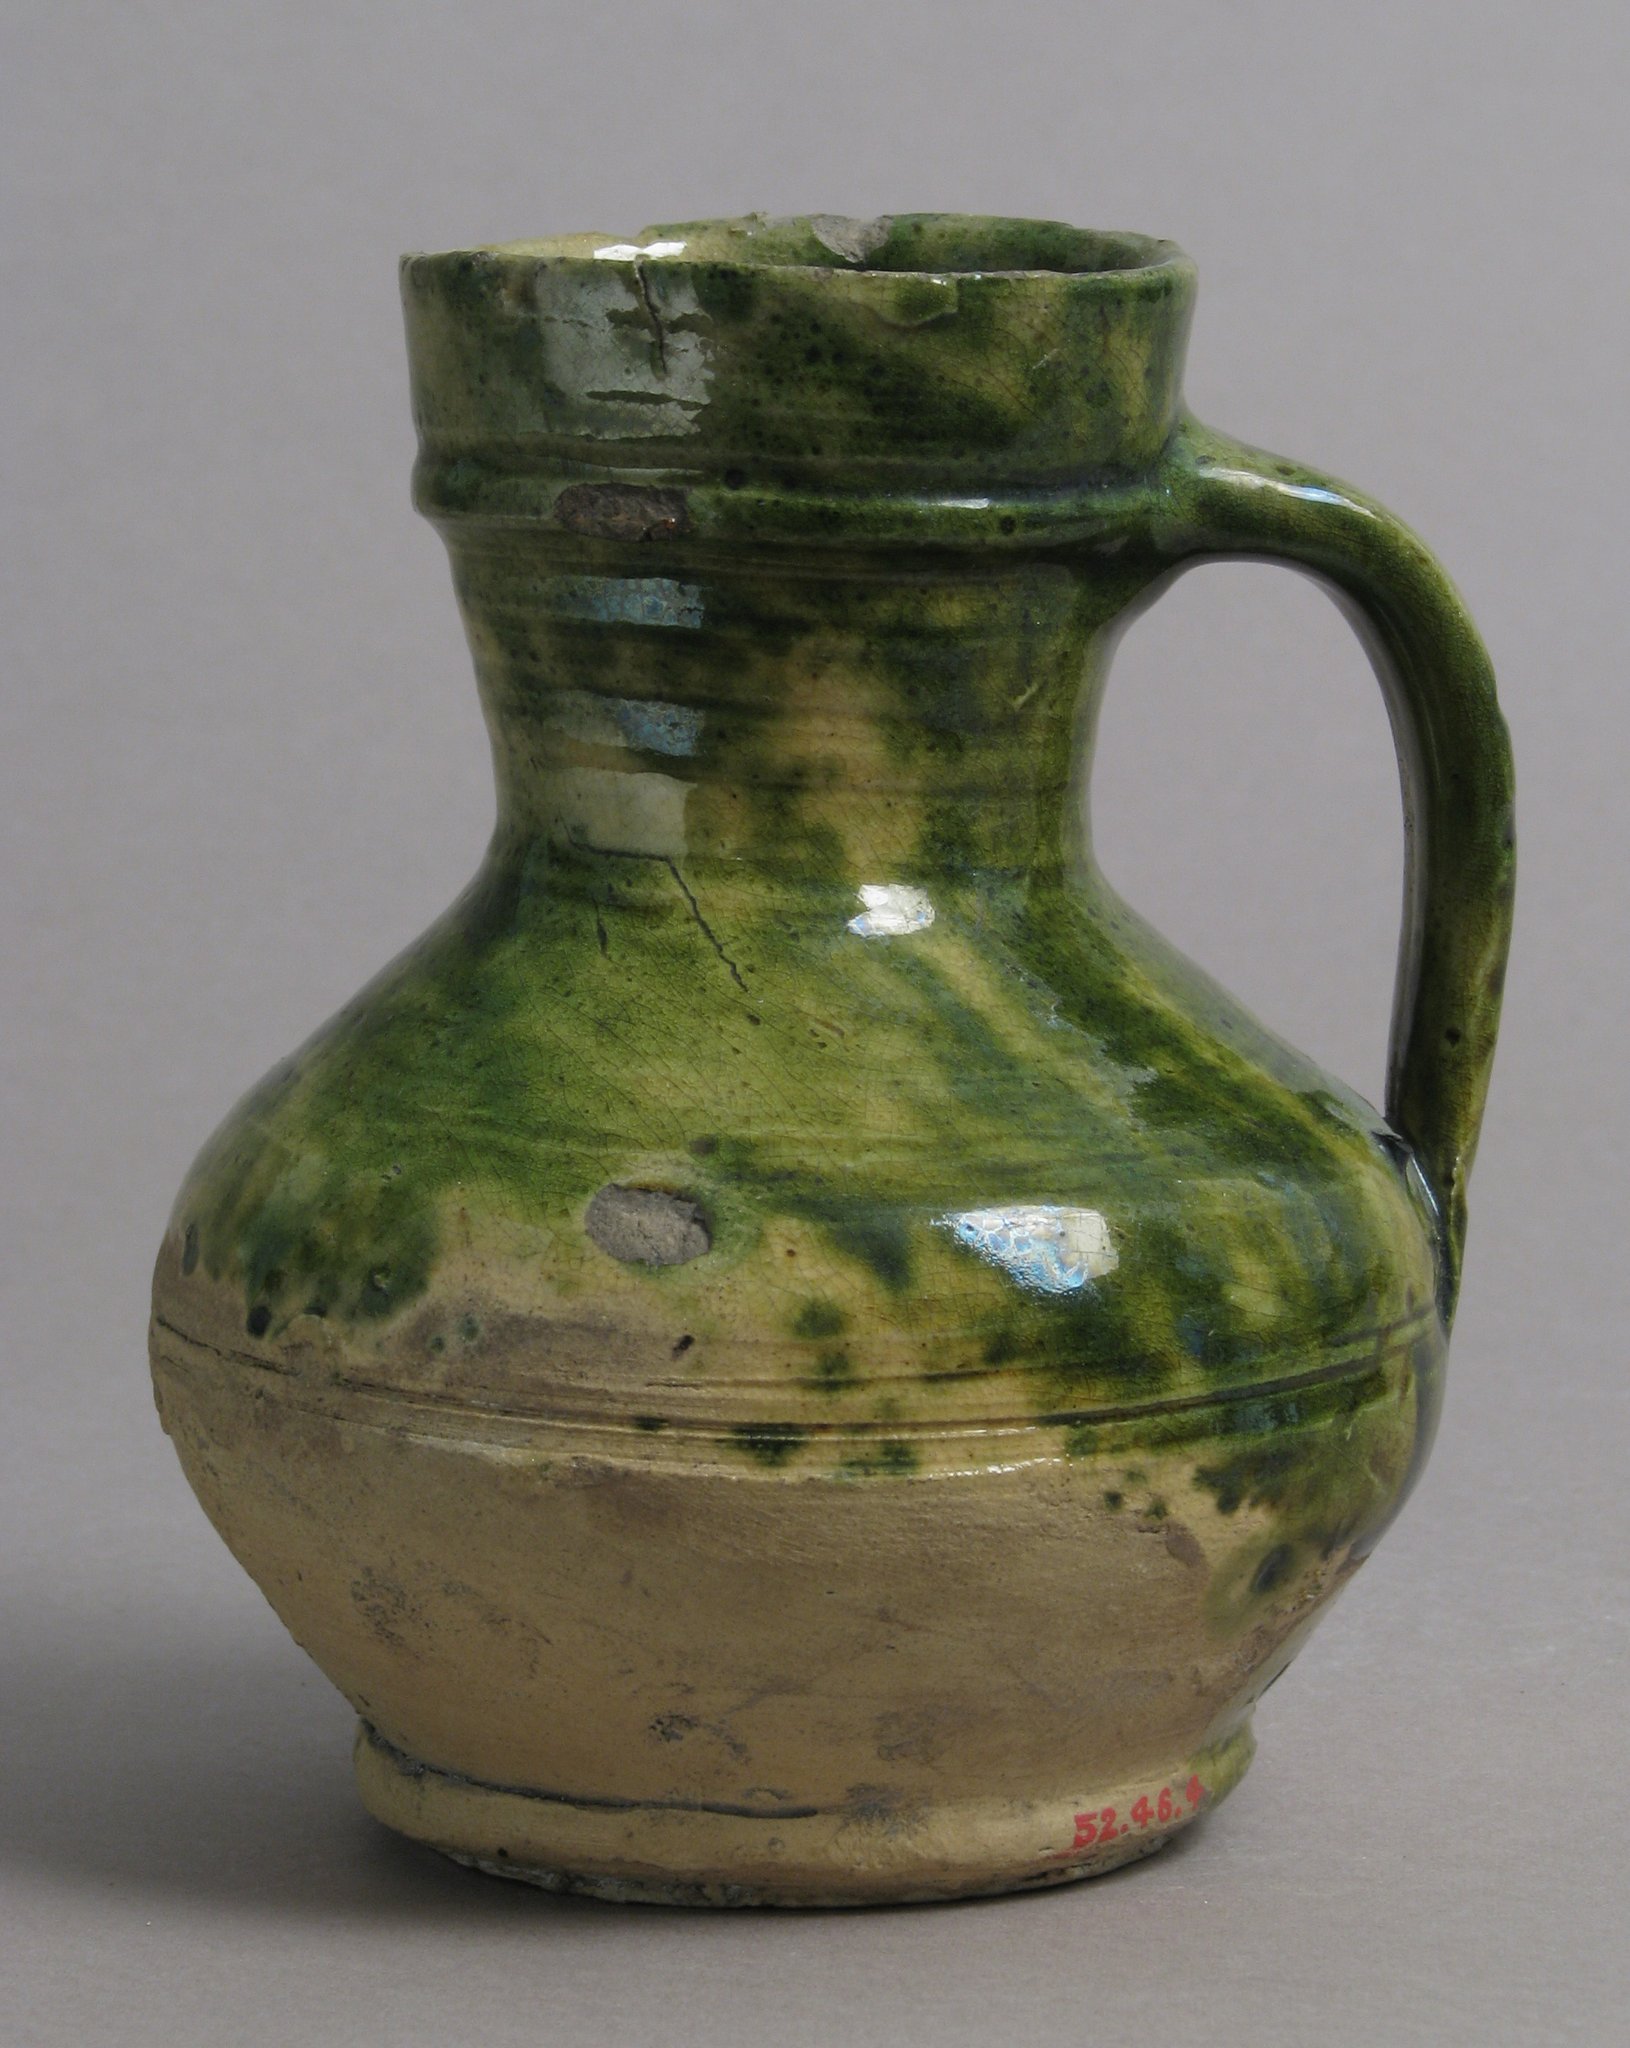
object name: jug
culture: british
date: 1401-1600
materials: earthenware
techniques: glazing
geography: england